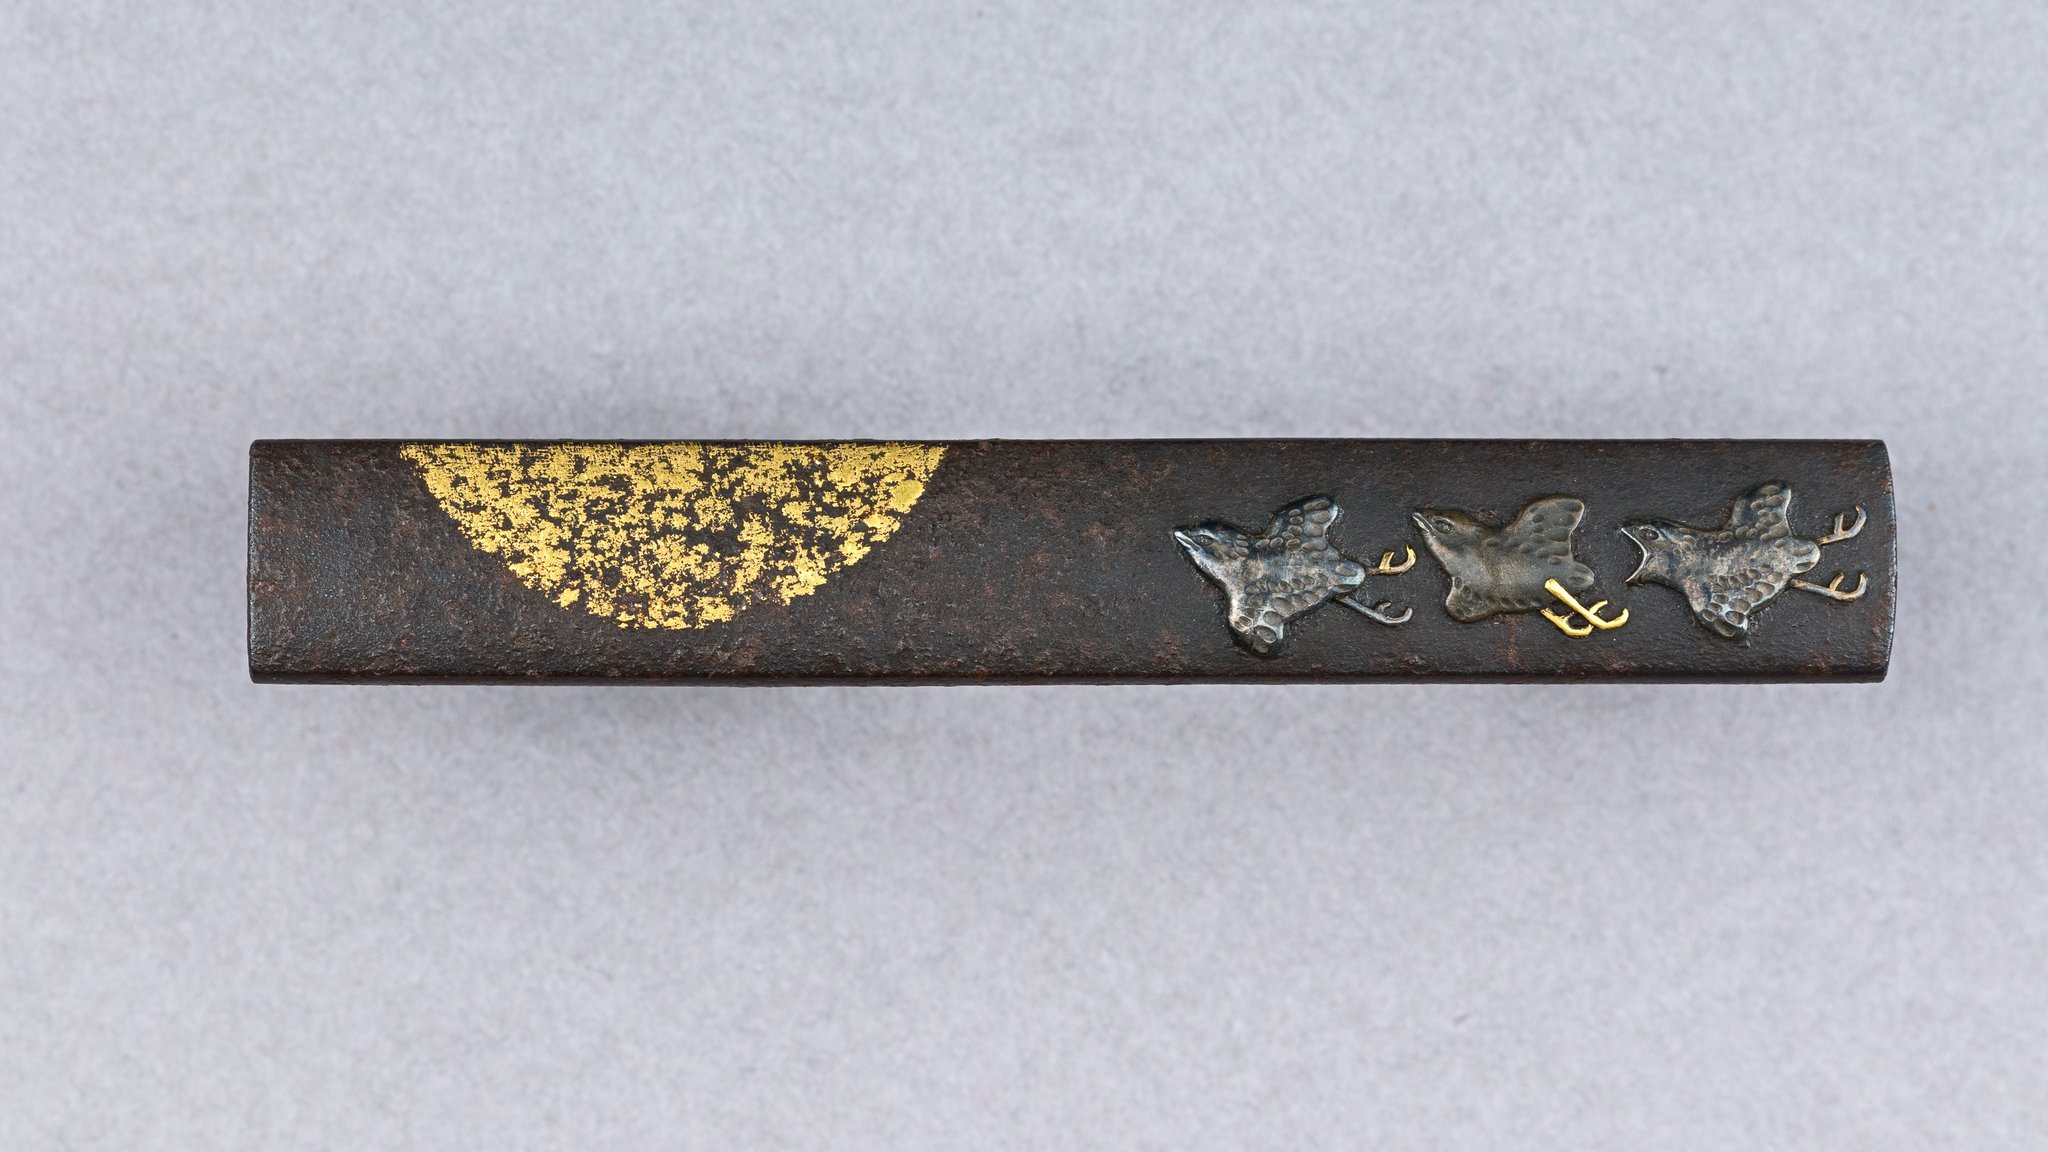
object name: knife handle kozuka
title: Knife Handle (Kozuka)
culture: japanese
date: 1701-1800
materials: silver alloy, gold, iron, silver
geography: japan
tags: birds